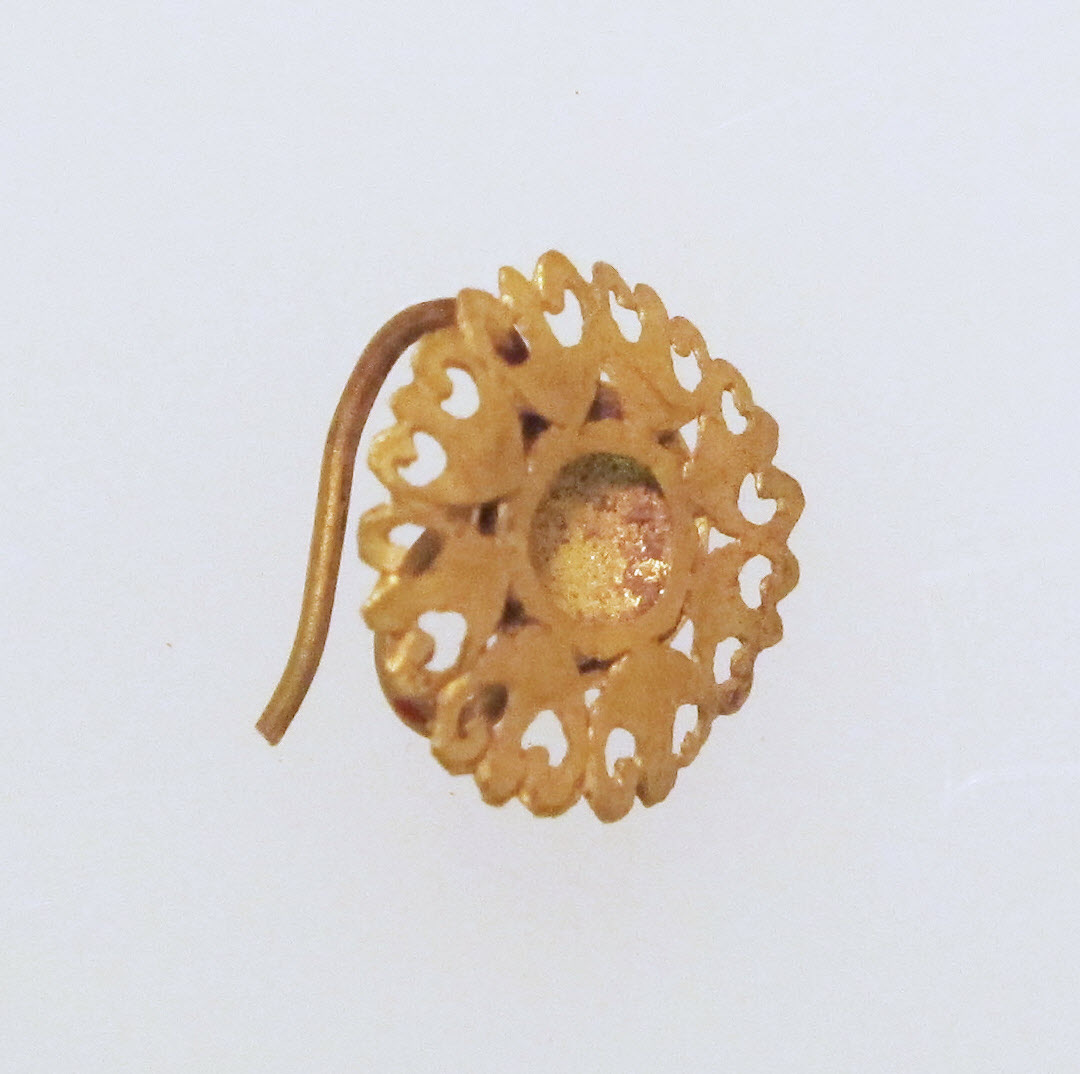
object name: earring hook type with disc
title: Earring-hook type with disc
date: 7000 BCE-330 CE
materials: gold